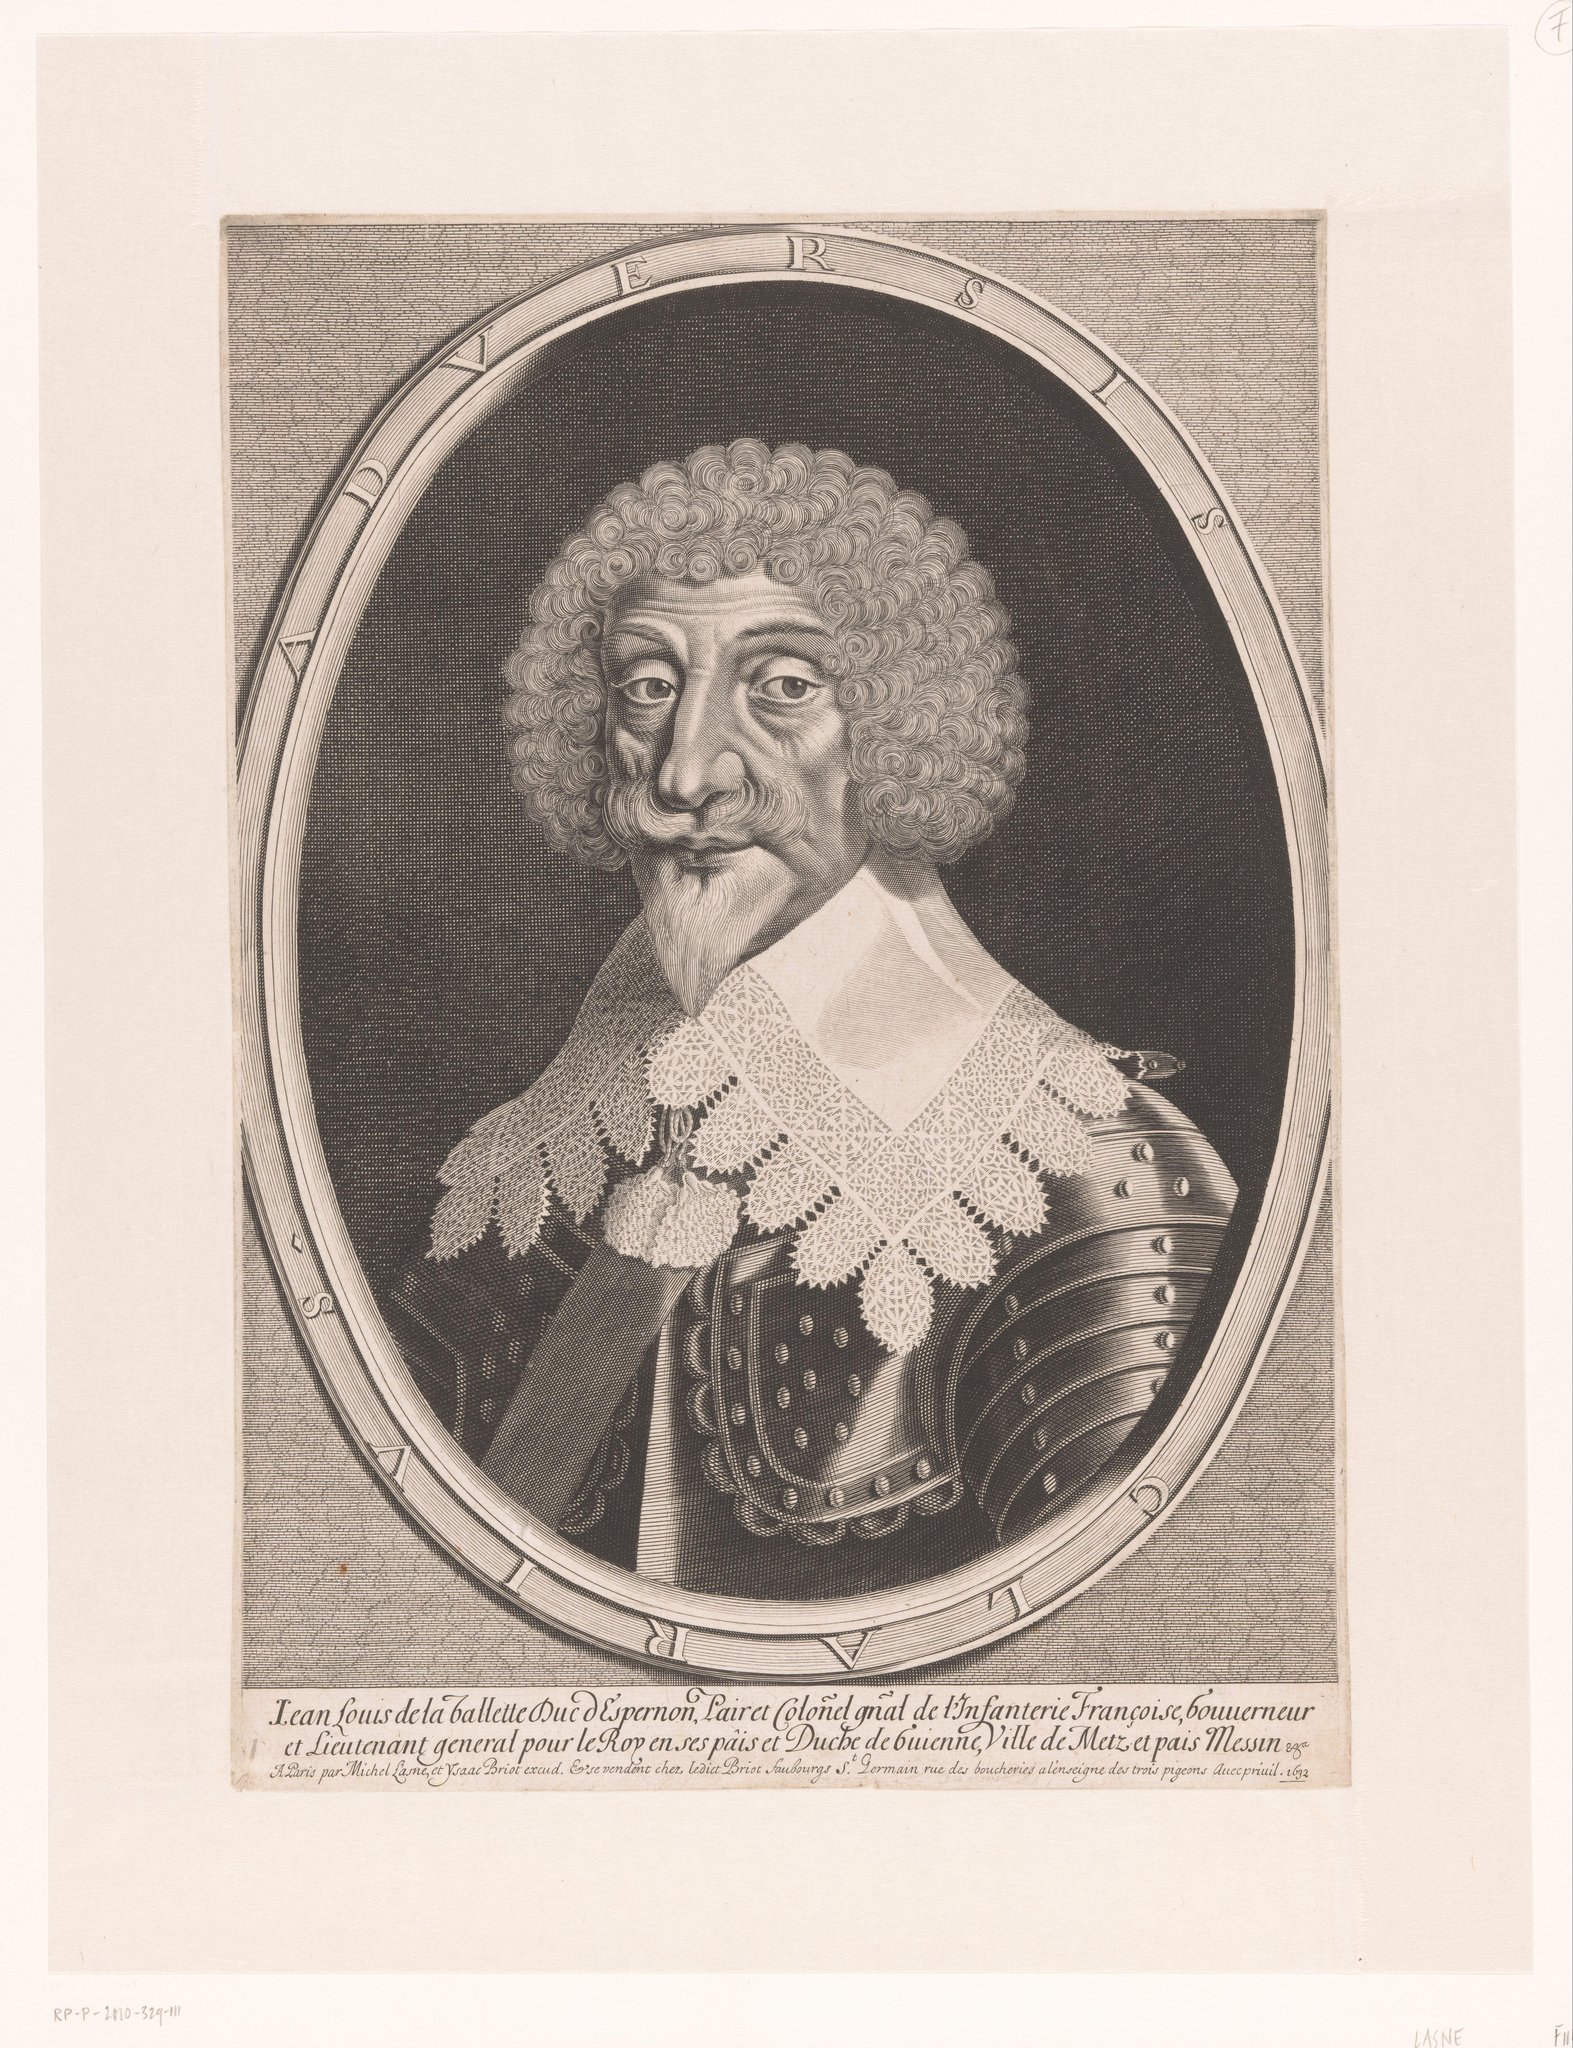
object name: print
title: Portrait of Jean-Louis de Nogaret de La Valette,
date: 1632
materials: paper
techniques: engraving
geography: paris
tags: politician, historical persons, commander-in-chief, admiral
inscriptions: inscription: ‘Admiral de france’, collector's mark: Lugt 2228, inscription: ‘v. Polianoff(?) 1930/ 740’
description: The printmaker Michel Lasne trained in the workshop of Rubens. However, the master did not find Lasne’s interplay of lines sufficiently dynamic for translating his paintings into prints. His taut style, however, did appeal to the French king Louis XIII and he was even appointed court engraver. In this capacity, Lasne engraved numerous portraits of members of the French court.